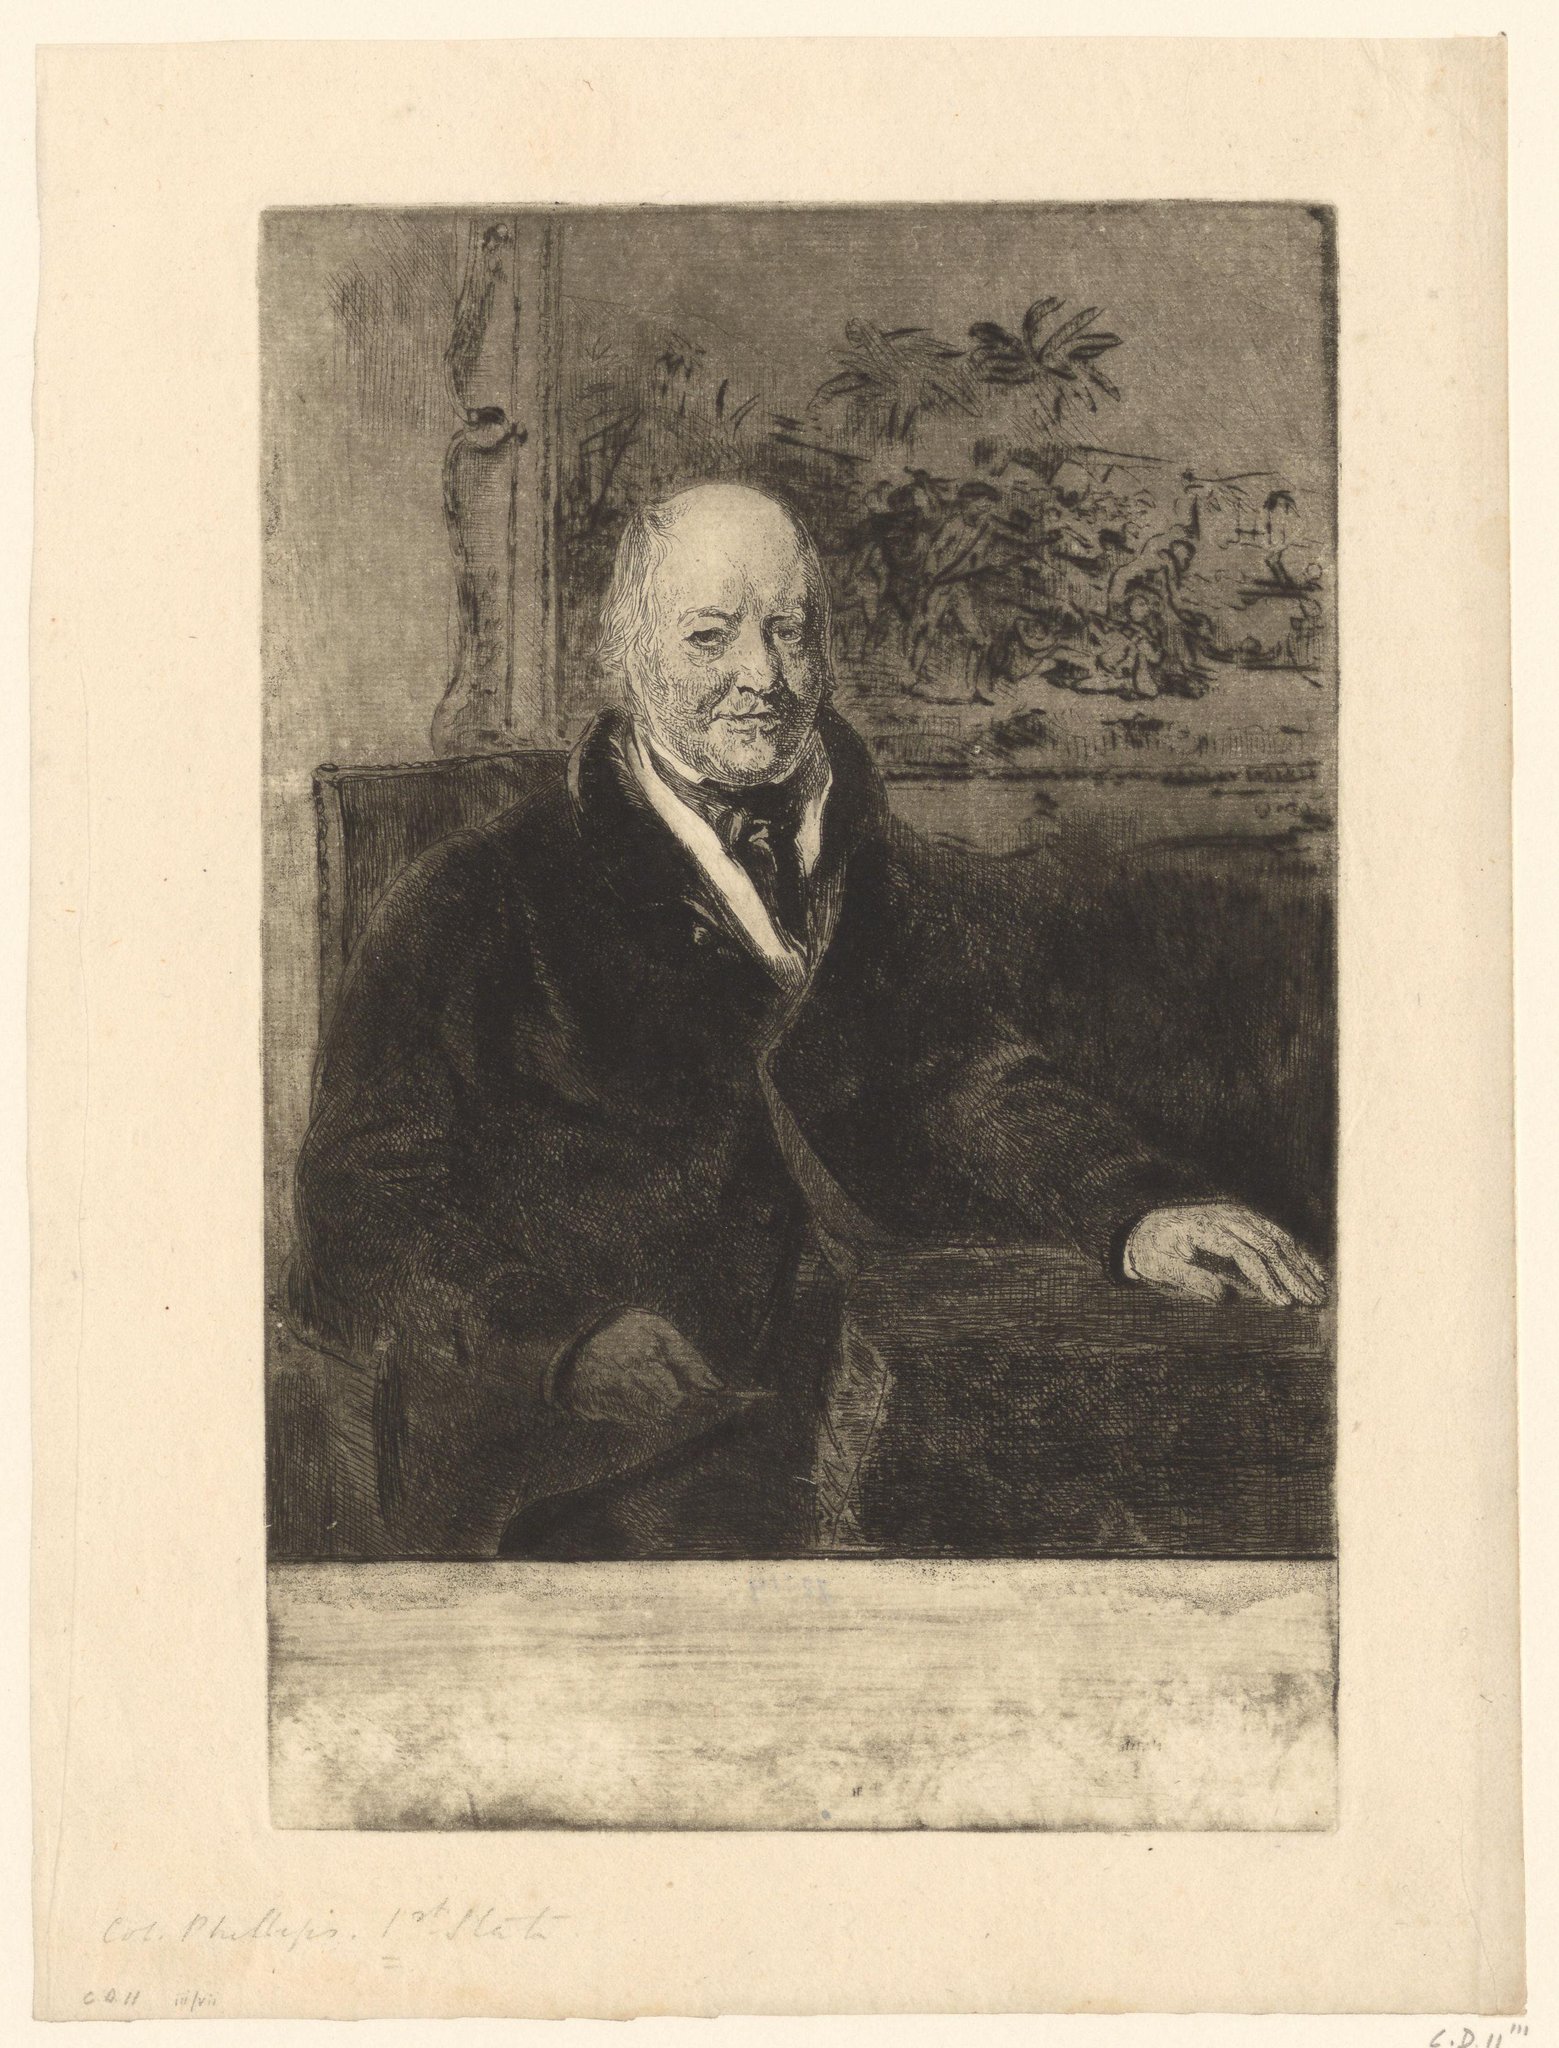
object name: print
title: Portret van Molesworth Phillips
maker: andrew geddes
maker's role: print maker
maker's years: 1783-1844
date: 1793-1844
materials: paper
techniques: drypoint, etching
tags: historical persons, commander-in-chief, admiral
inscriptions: collector's mark: Lugt 2228, collector's mark: Lugt 2760